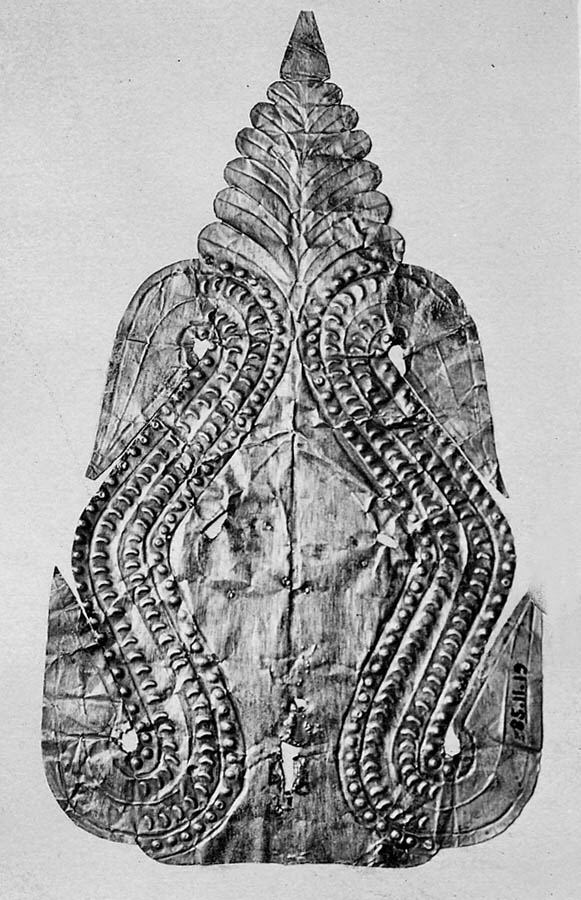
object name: ornament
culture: cambodian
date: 1701-1800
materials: silver